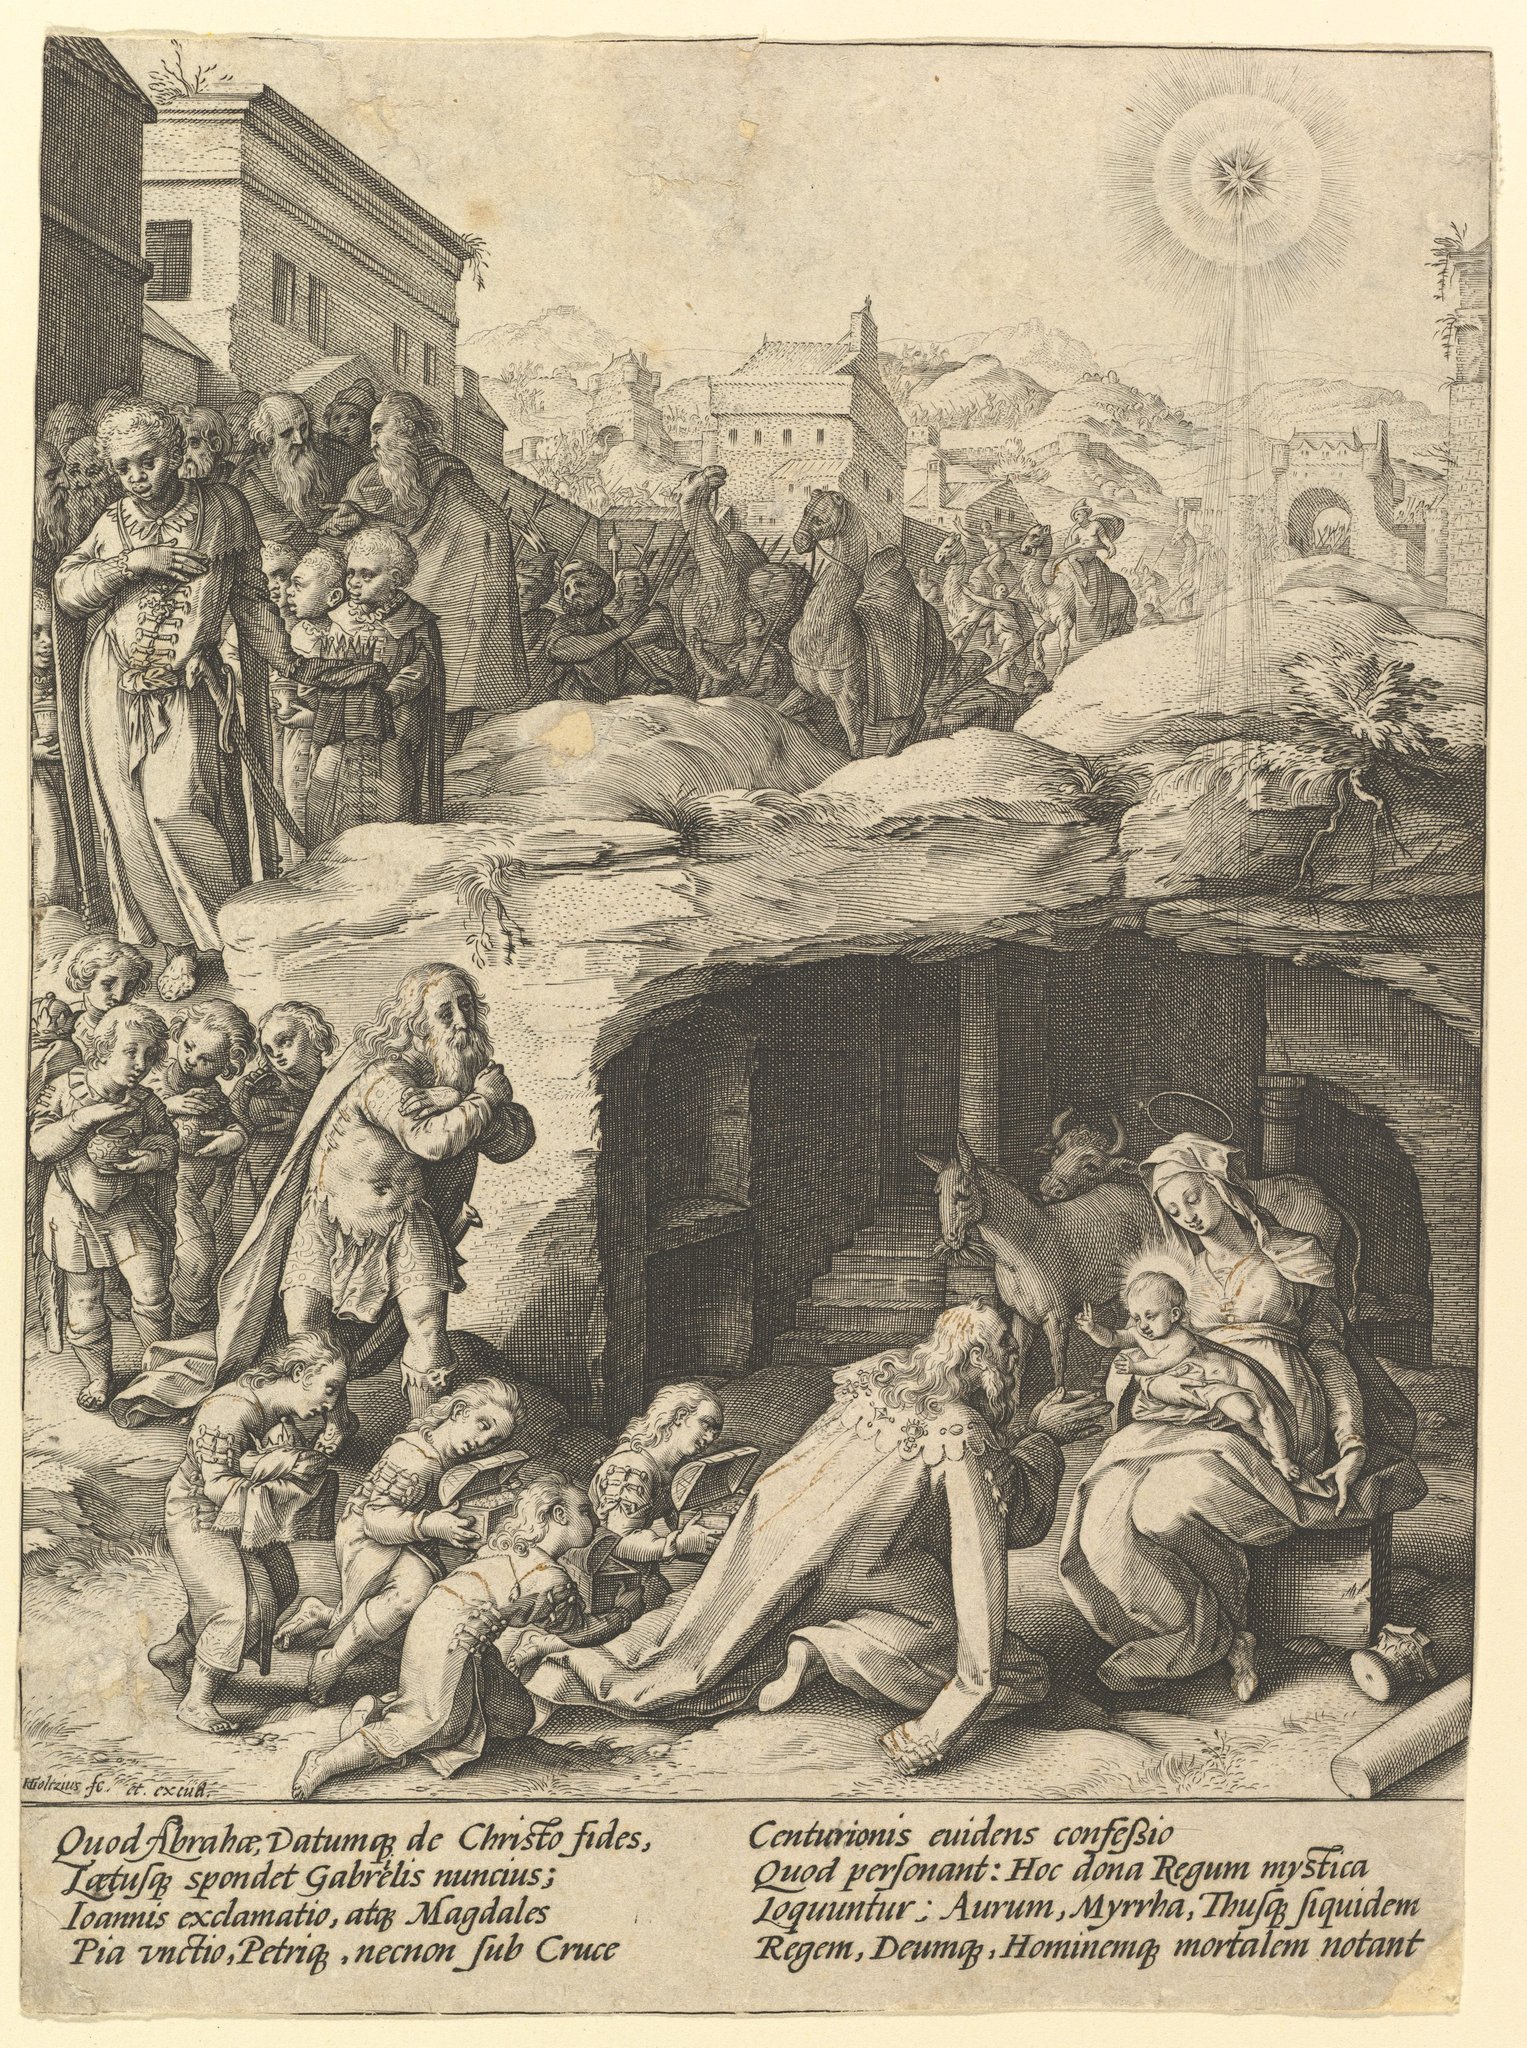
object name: print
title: The Adoration of the Magi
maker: hendrick goltzius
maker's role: artist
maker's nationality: netherlandish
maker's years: 1558-1617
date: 1585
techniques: engraving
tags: adoration of the magi